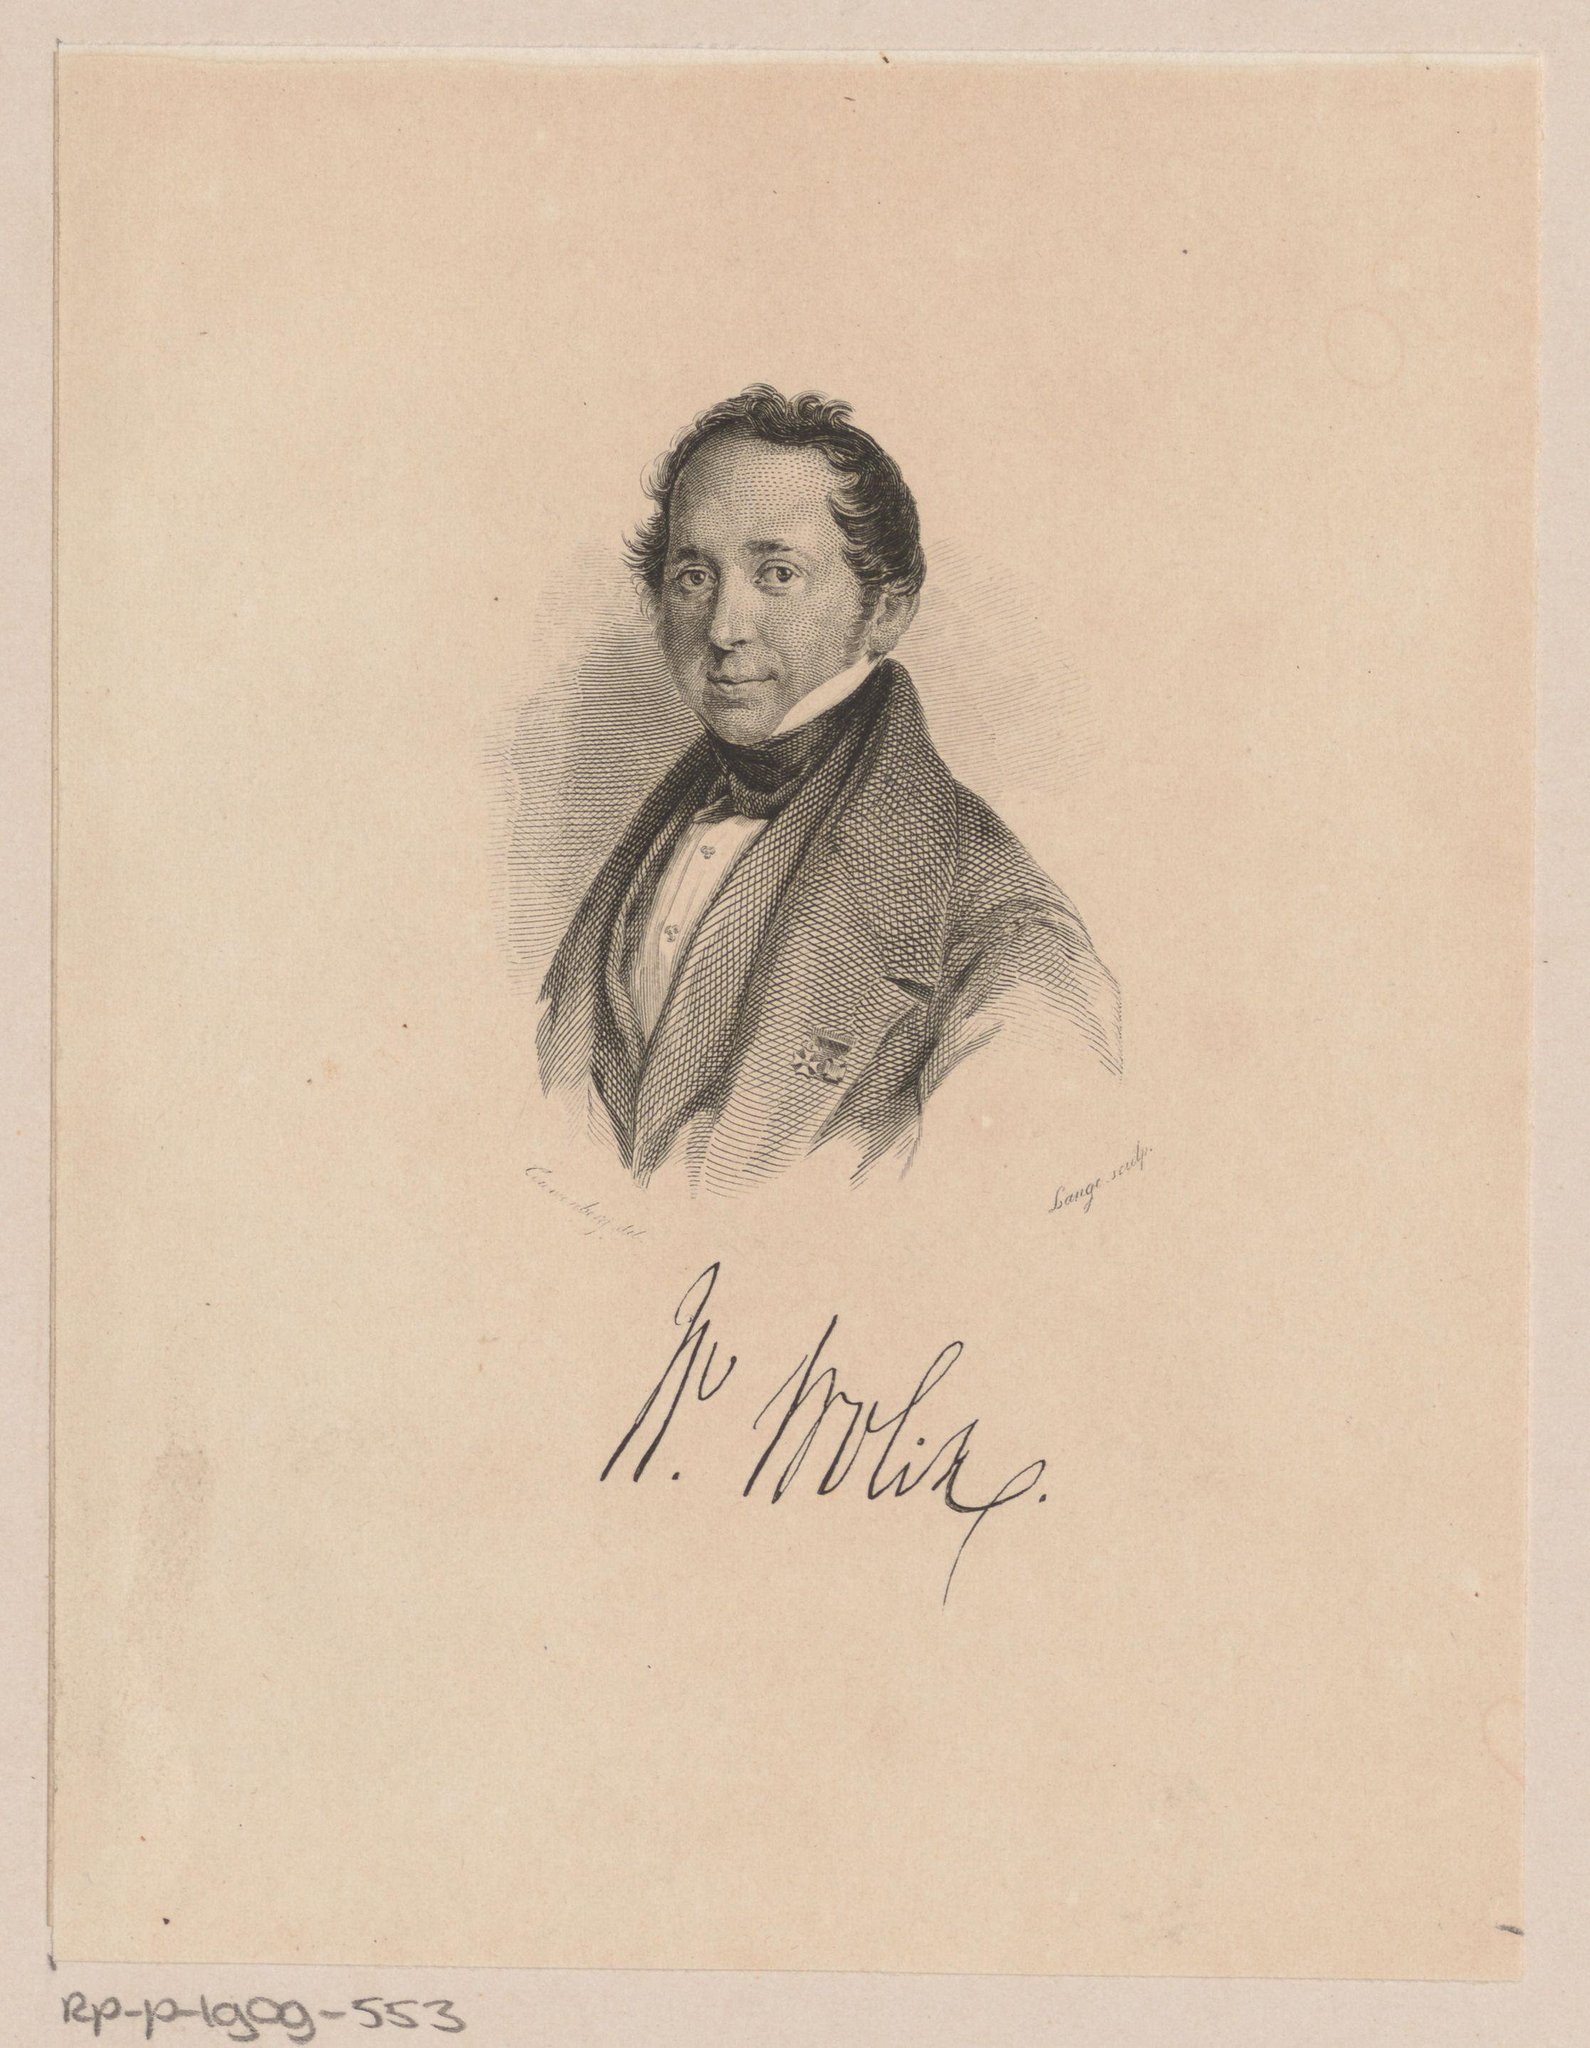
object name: print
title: Portret van Willem Vrolik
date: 1841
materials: paper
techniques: etching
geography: netherlands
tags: scholar, philosopher, historical persons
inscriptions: collector's mark: Lugt 2228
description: Prent waarschijnlijk uit: Amsterdamsche Studentenalmanak (1841).